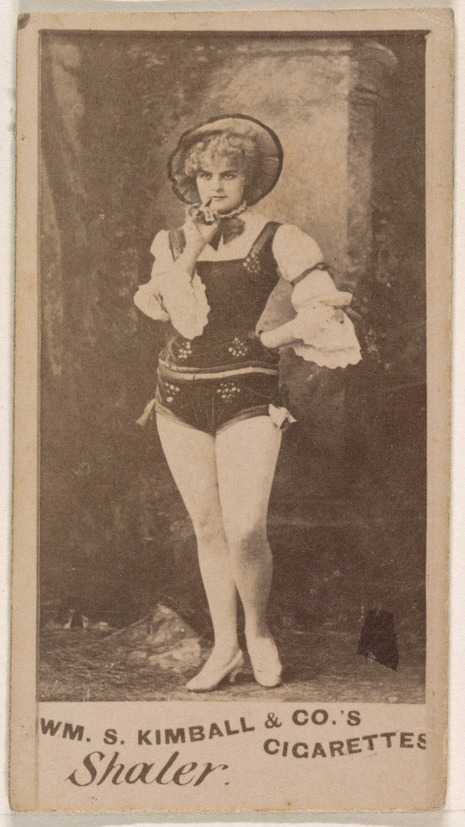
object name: photograph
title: Miss Shaler, from the Actresses series (N203) issued by Wm. S. Kimball & Co.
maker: william s. kimball & company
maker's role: publisher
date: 1889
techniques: color lithograph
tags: portraits,women,actresses